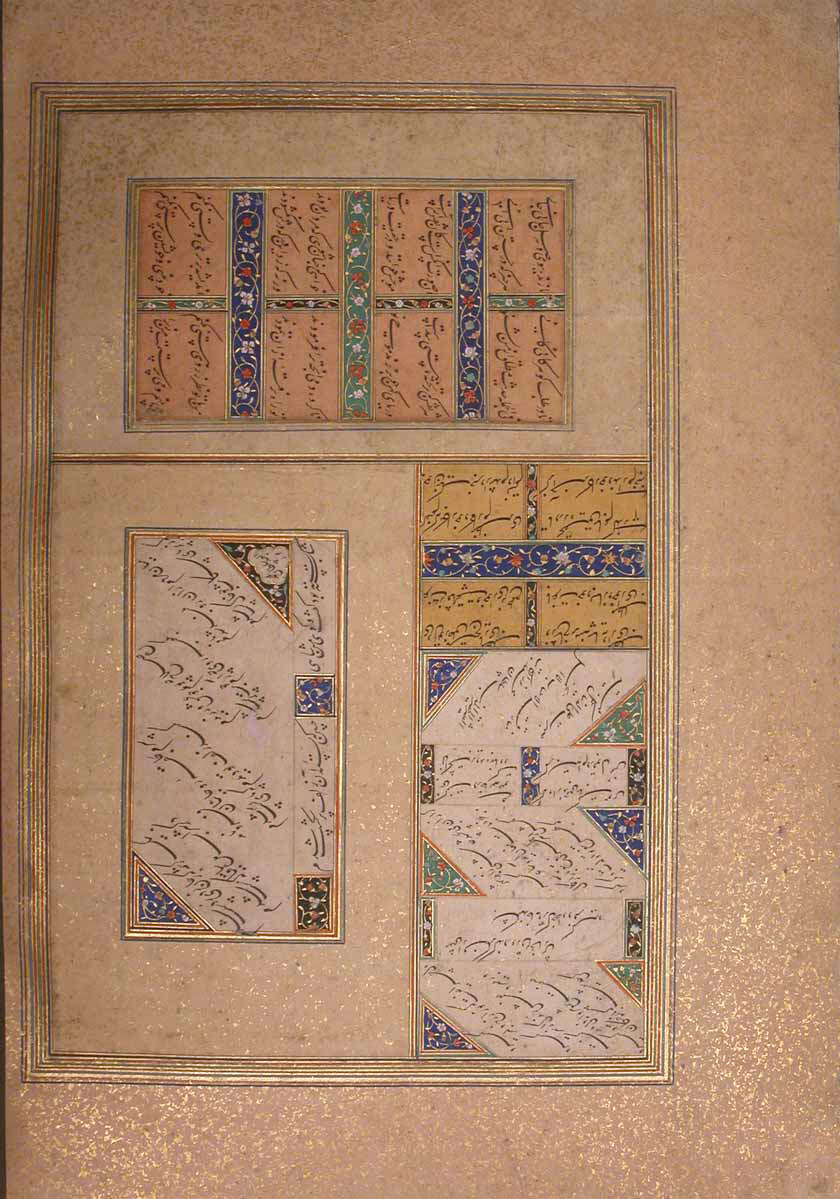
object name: non illustrated album leaf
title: Page of Calligraphy from the Bellini Album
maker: sultan muhammad nur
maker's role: calligrapher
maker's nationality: iranian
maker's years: 1448-1561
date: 1600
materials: gold, ink, paper, watercolor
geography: iran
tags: calligraphy